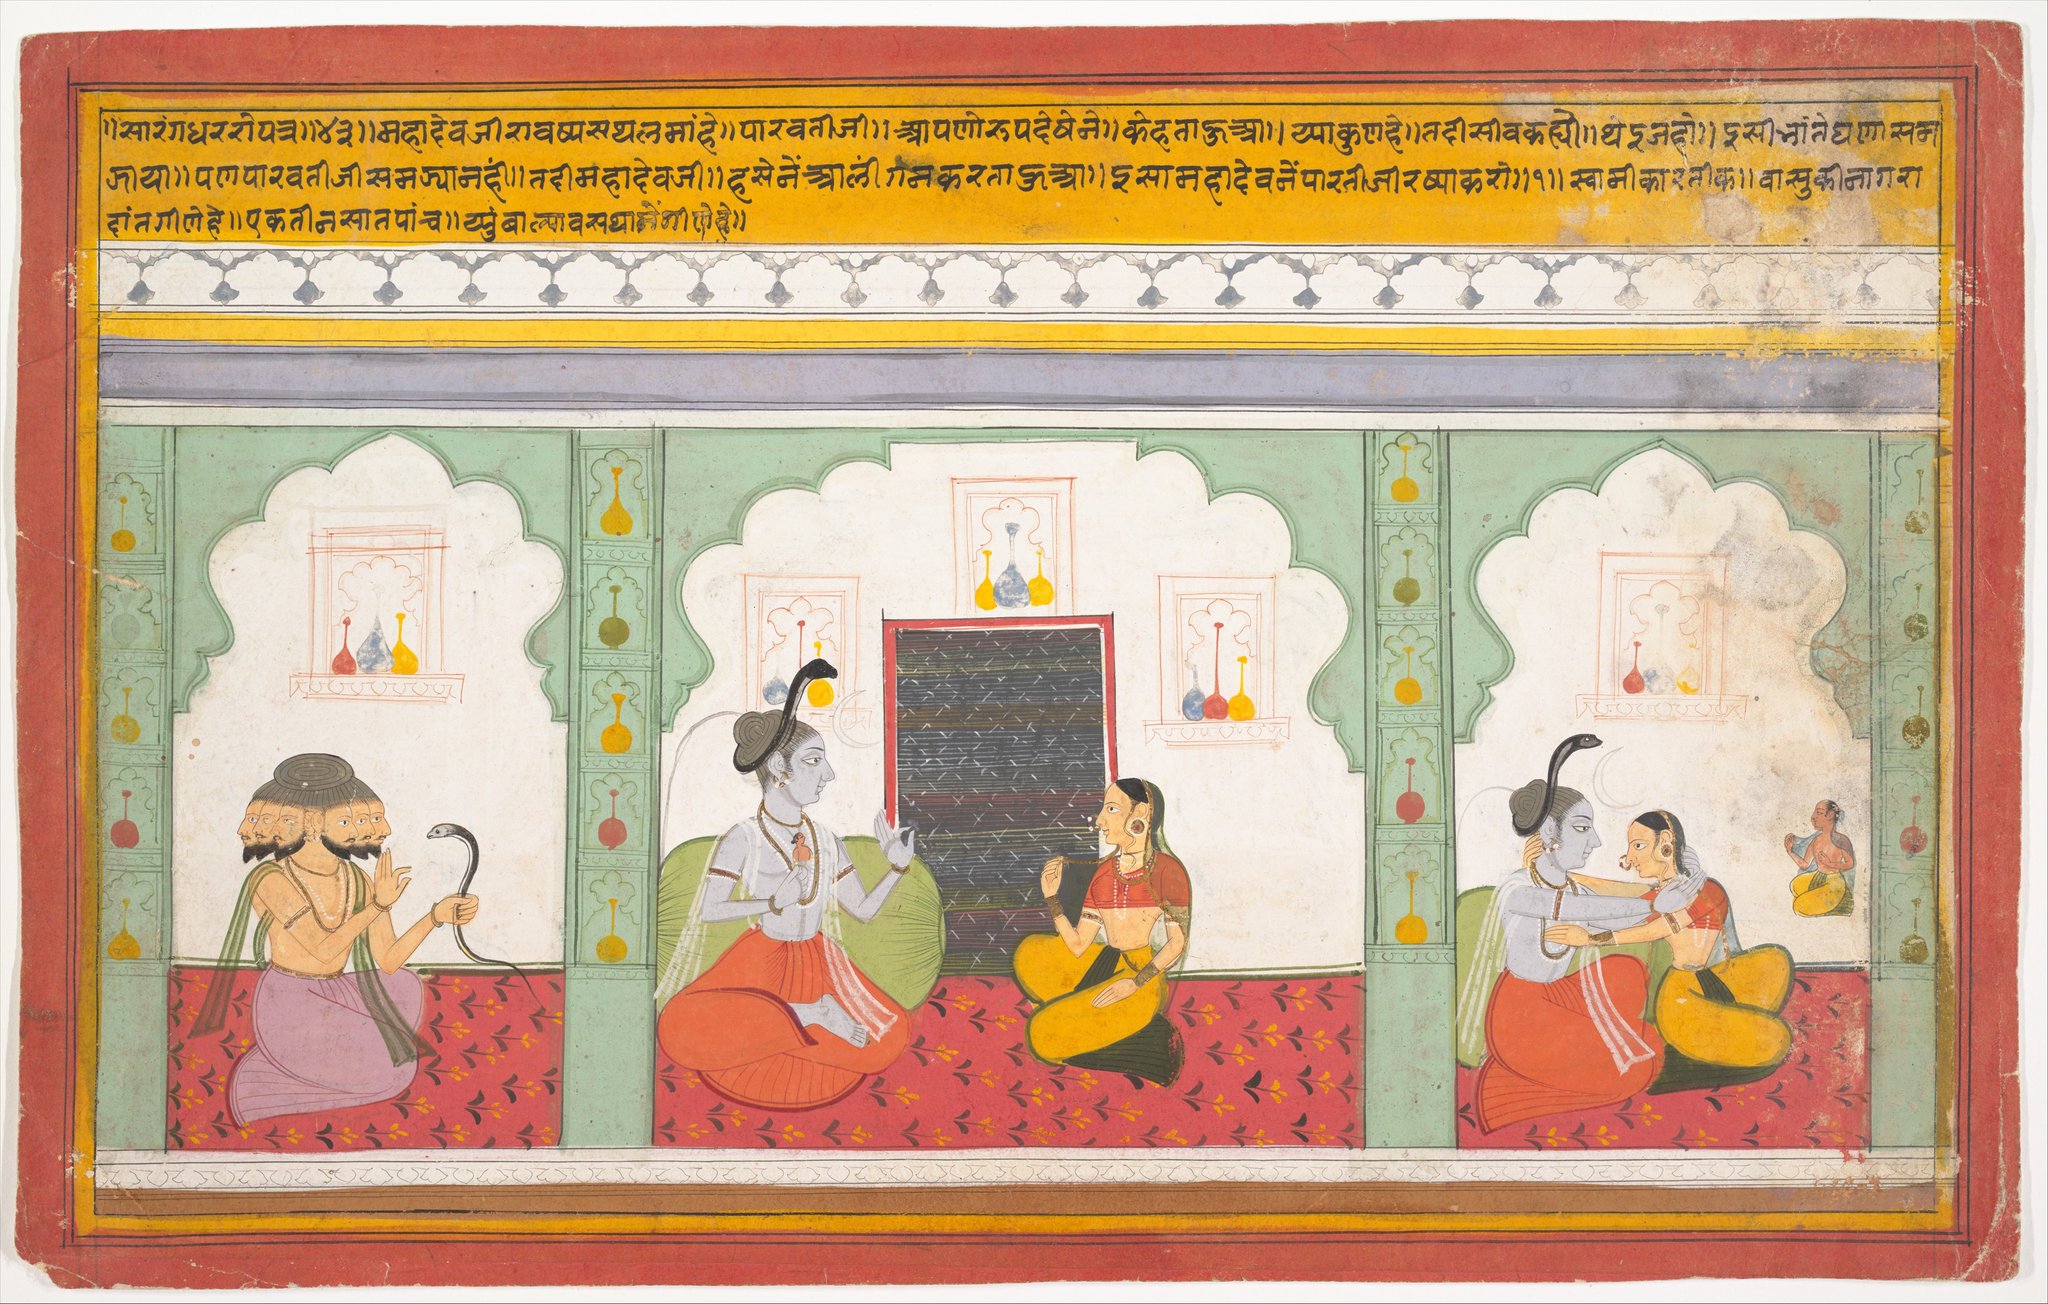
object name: folio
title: Page from a Dispersed Shiva Mahatmya (Great Tales of Shiva)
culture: mewar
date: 1710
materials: ink, paper, watercolor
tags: women,snakes,shiva